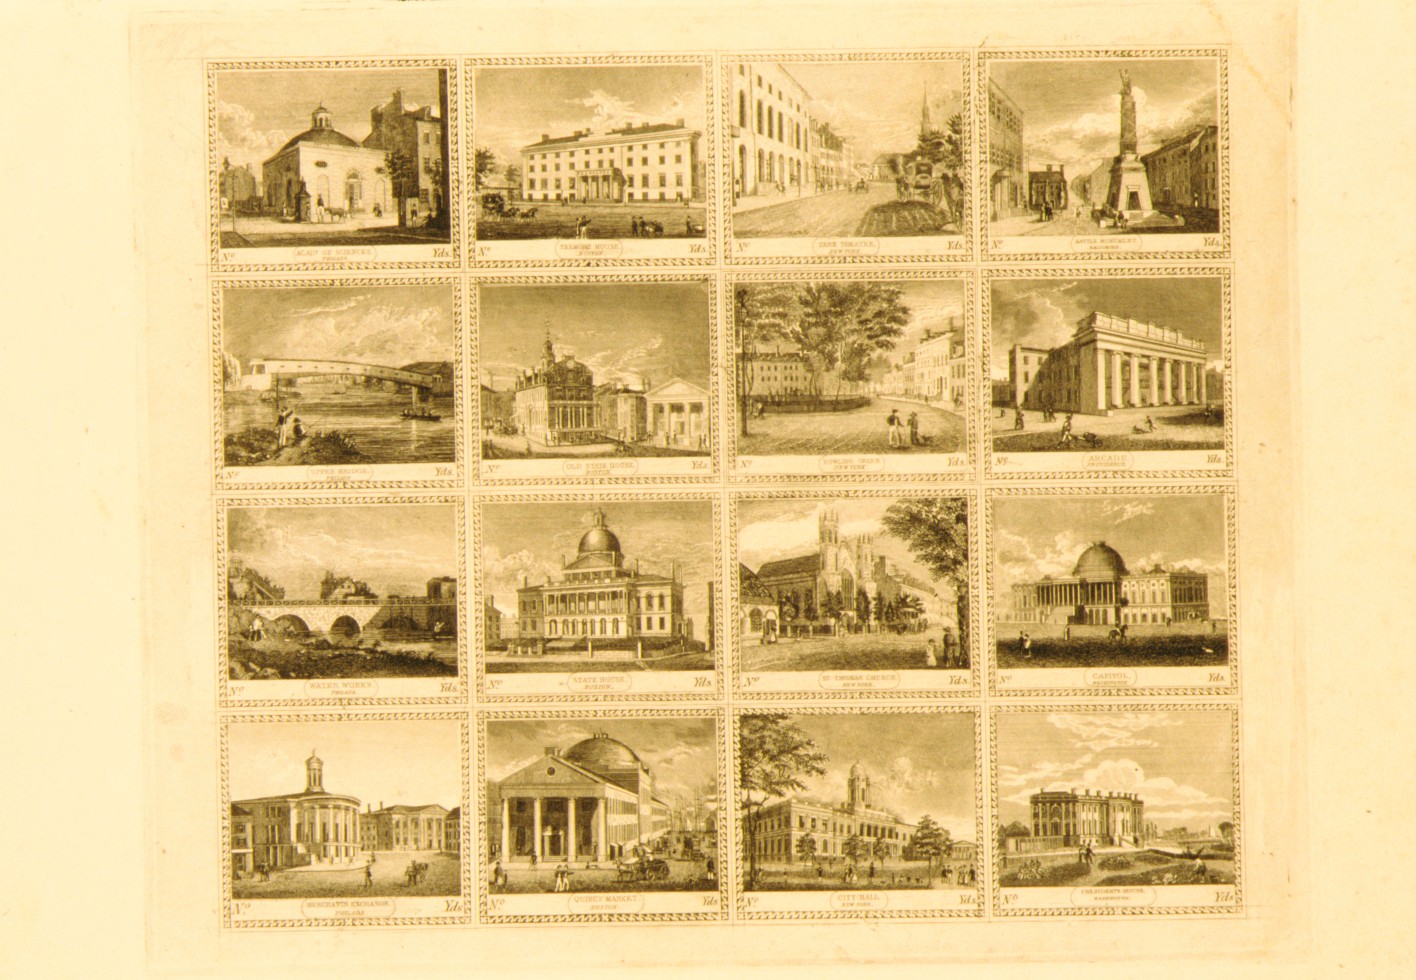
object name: print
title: Sheet of Fabric Labels with Sixteen Views of Buildings in Boston, New York, Philadelphia, Baltimore, Providence and Washington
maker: anonymous, american, 19th century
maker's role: artist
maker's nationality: american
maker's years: 1800-1900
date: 1835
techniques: engraving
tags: buildings